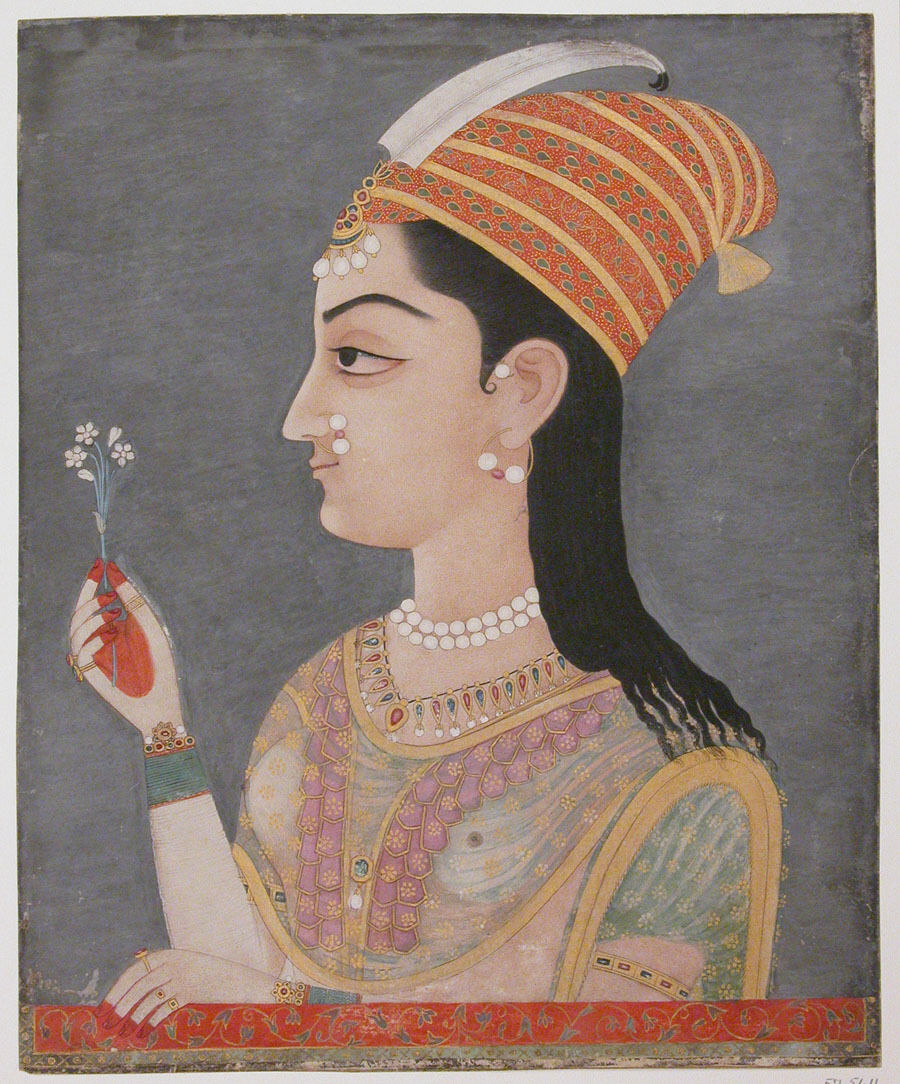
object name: illustrated single work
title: Portrait of a Lady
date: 1667-1800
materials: gold, paper, watercolor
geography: india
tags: profiles,women